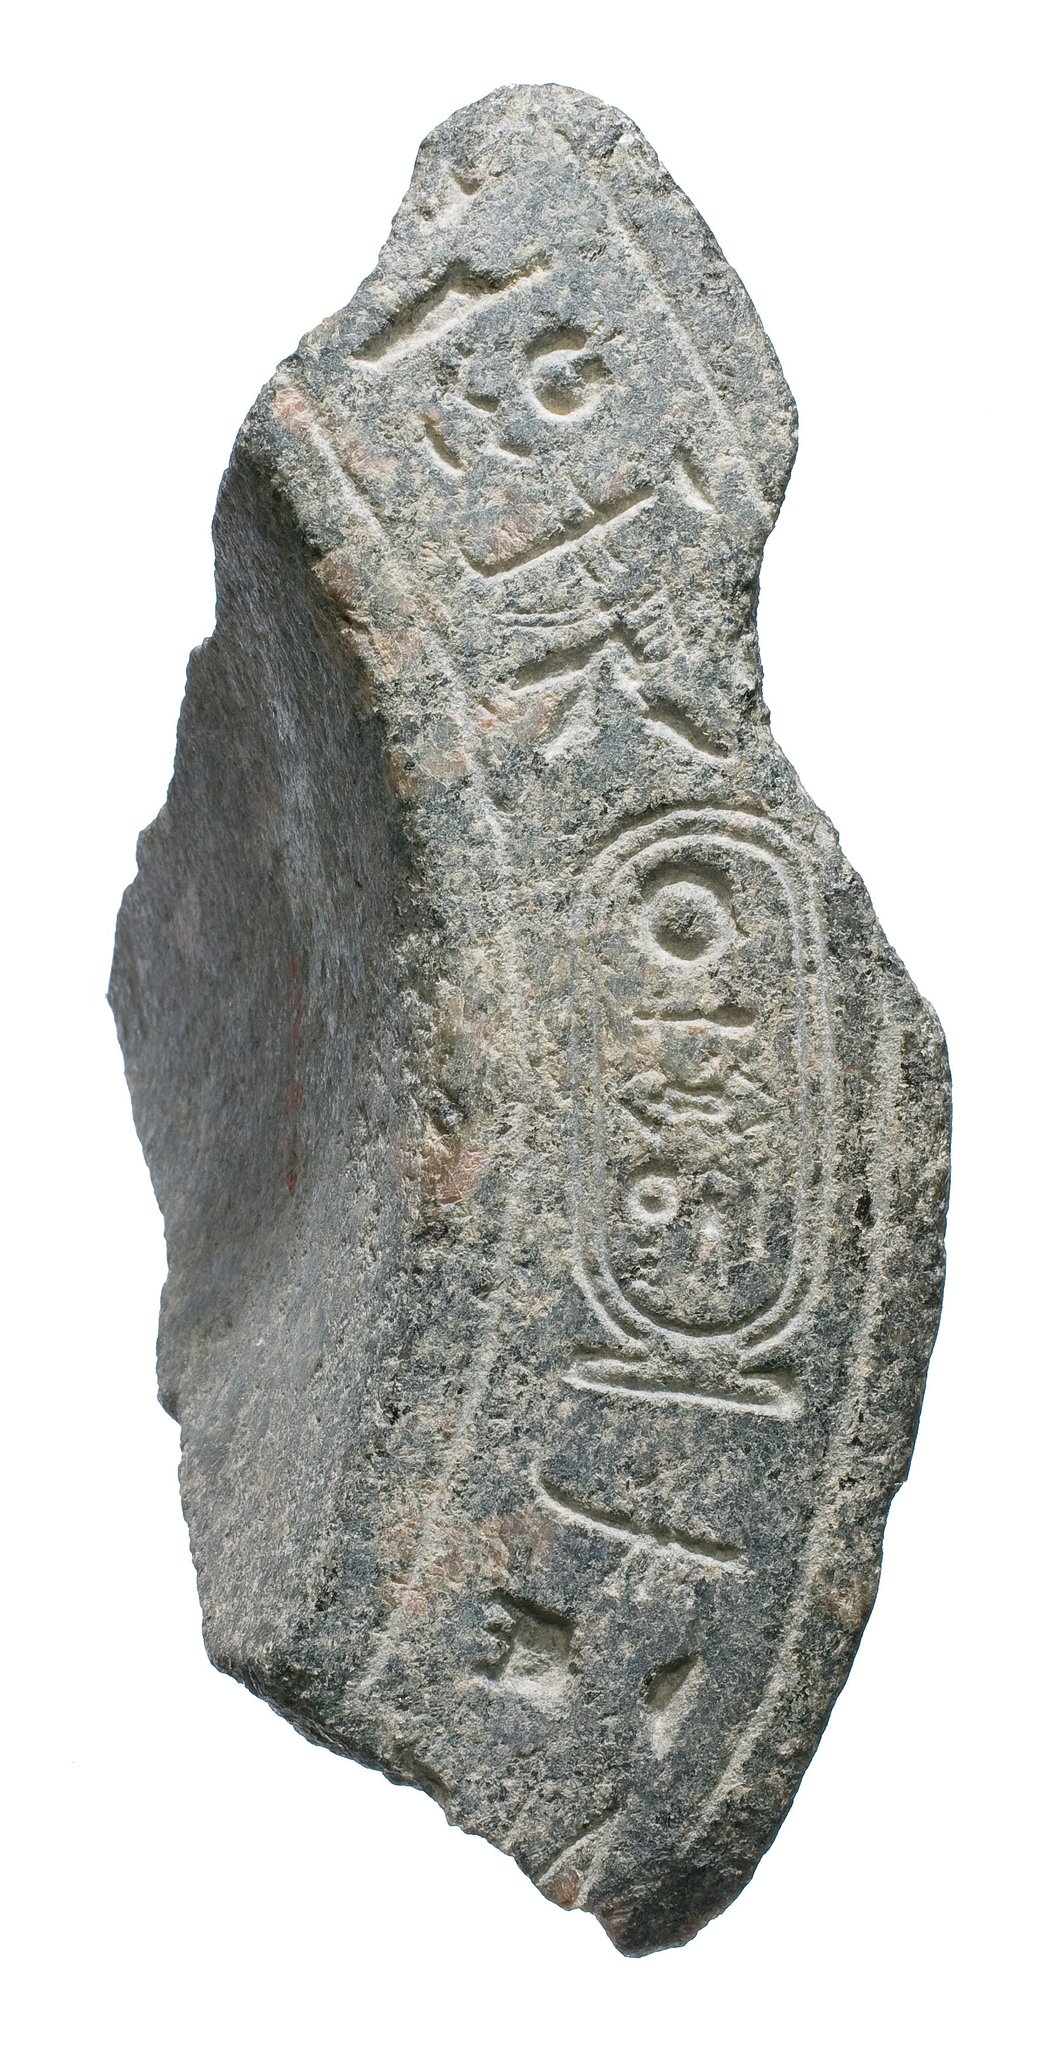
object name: akhenaten prenomen, basin or vessel rim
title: Rim from a libation basin l (?) with the prenomen of Akhenaten alone followed by the queen's titles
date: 1353-1336 BCE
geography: egypt